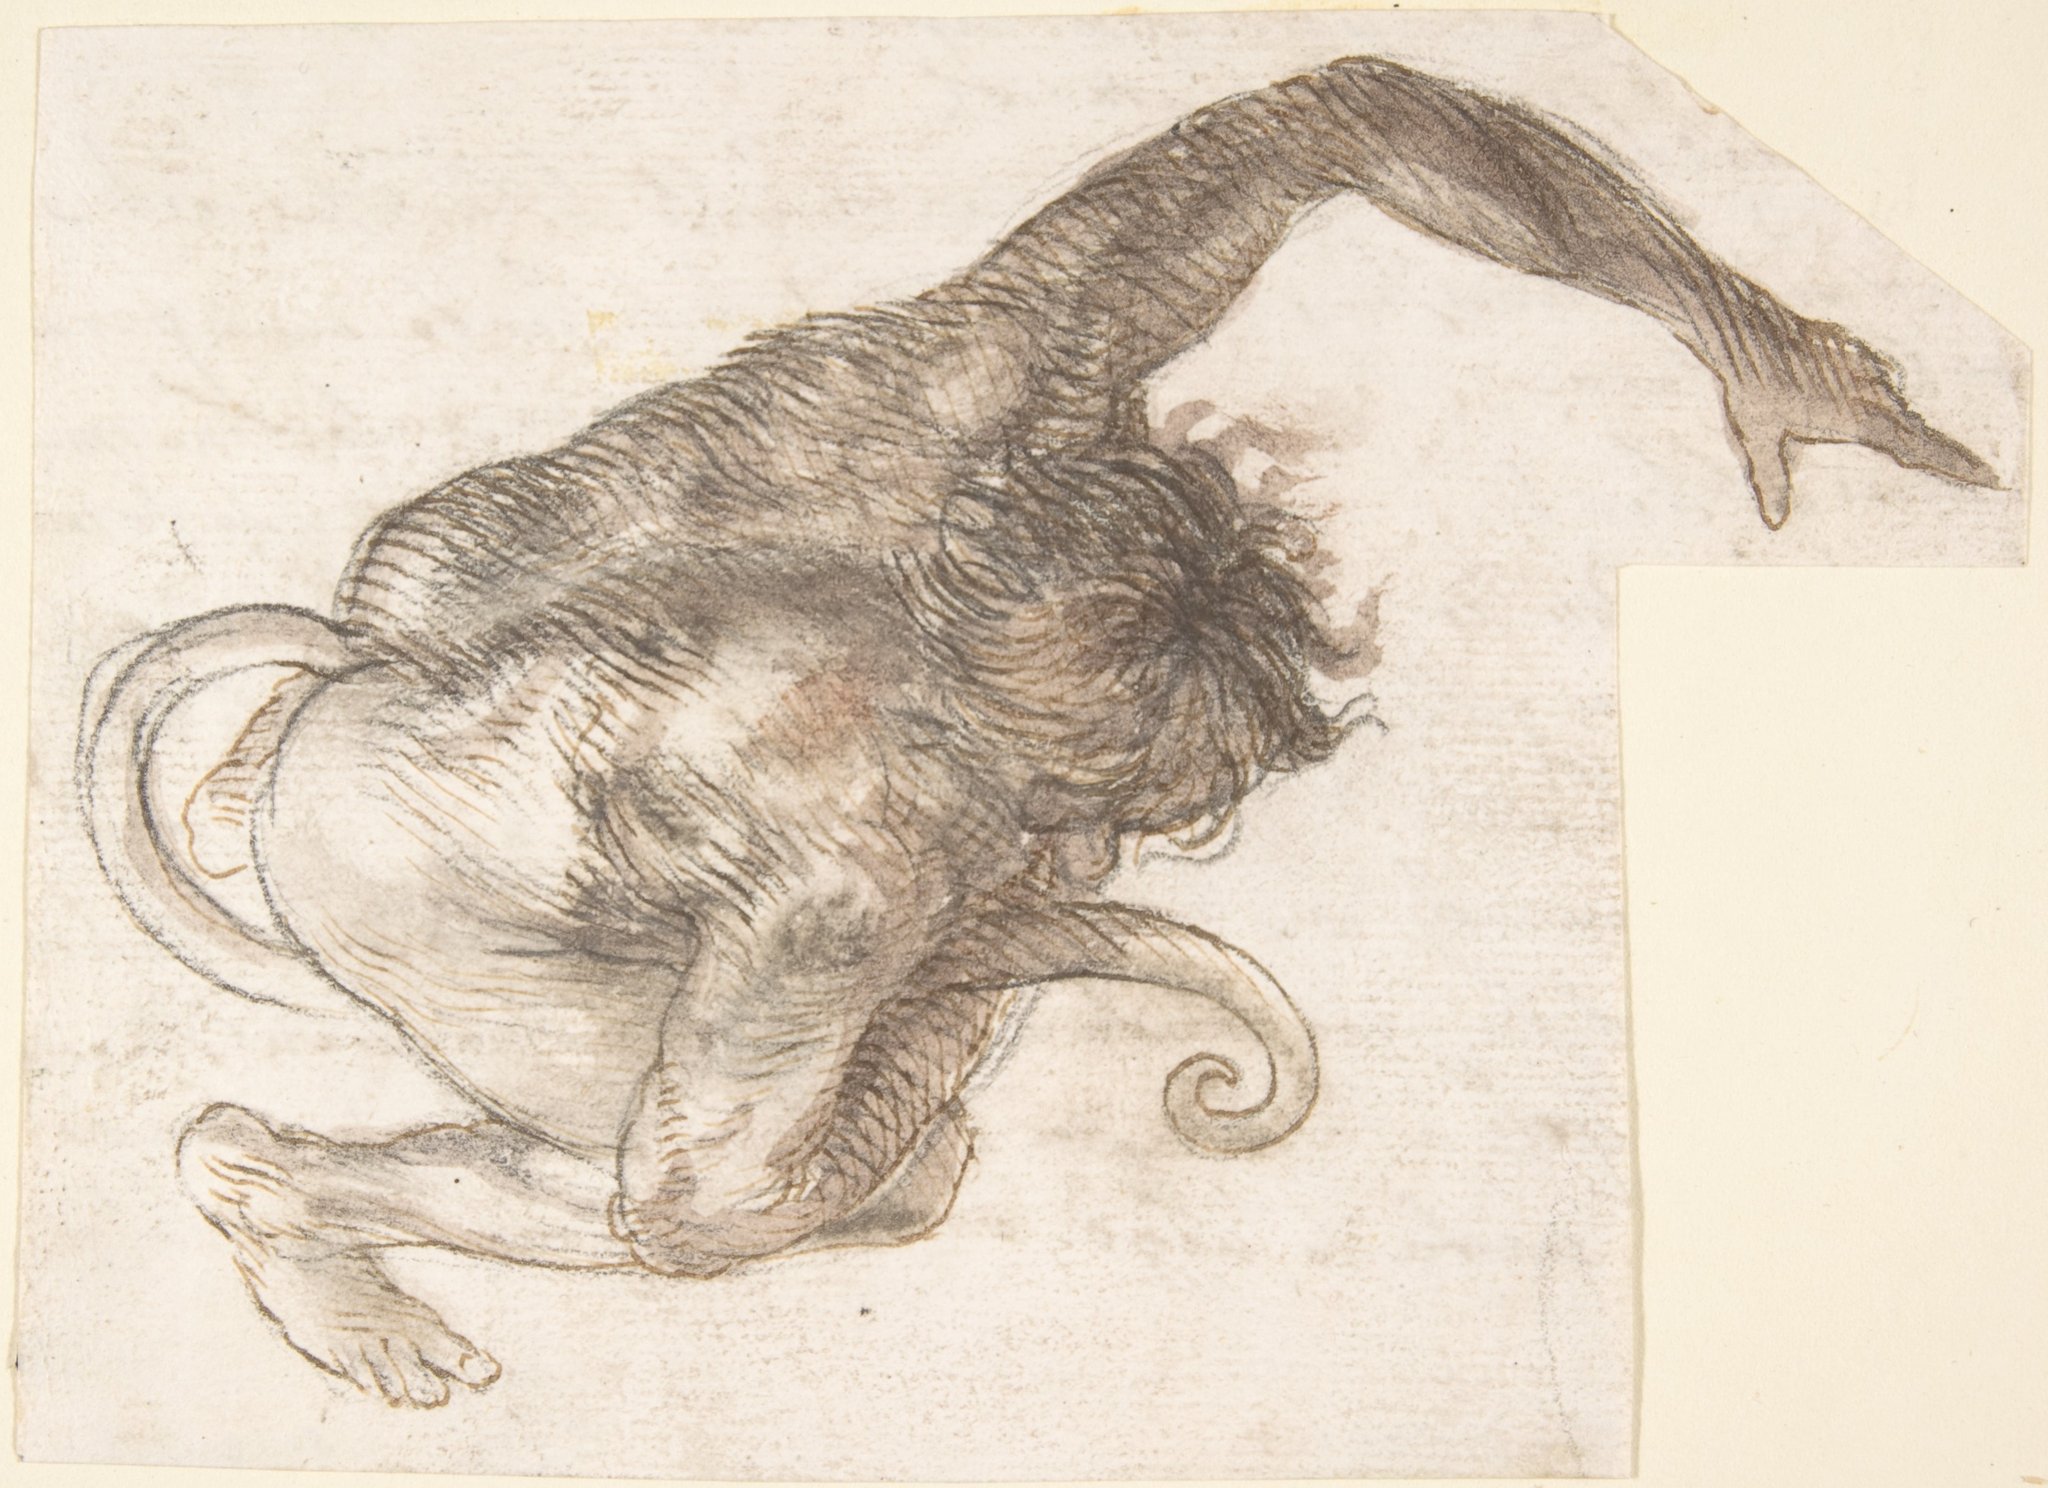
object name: drawing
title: Figure of Fantastic Human-like Creature with Long Tail (recto); Fragment of a Letter or Document (verso)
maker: anonymous, spanish, school of seville, 17th century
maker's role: artist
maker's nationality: spanish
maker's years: 1600-1700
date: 1601-1700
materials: chalk, ink, ivory, paper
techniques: brush, pen, drawing, wash